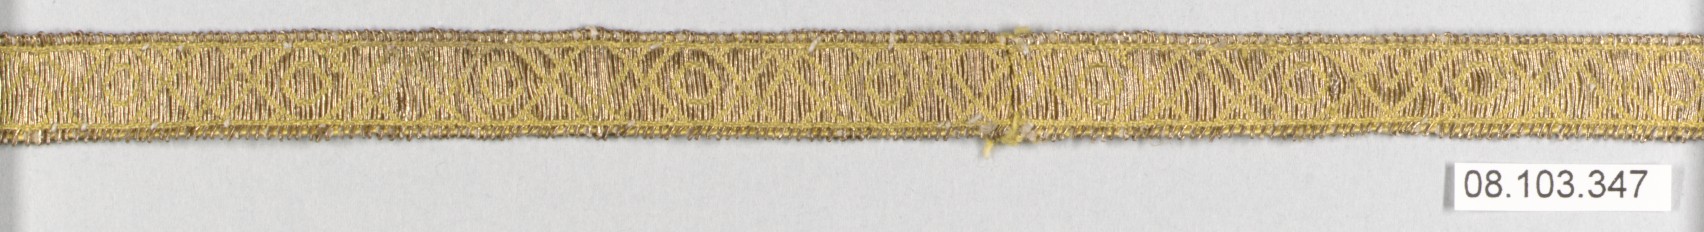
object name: galloon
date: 1601-1800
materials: metal thread, silk